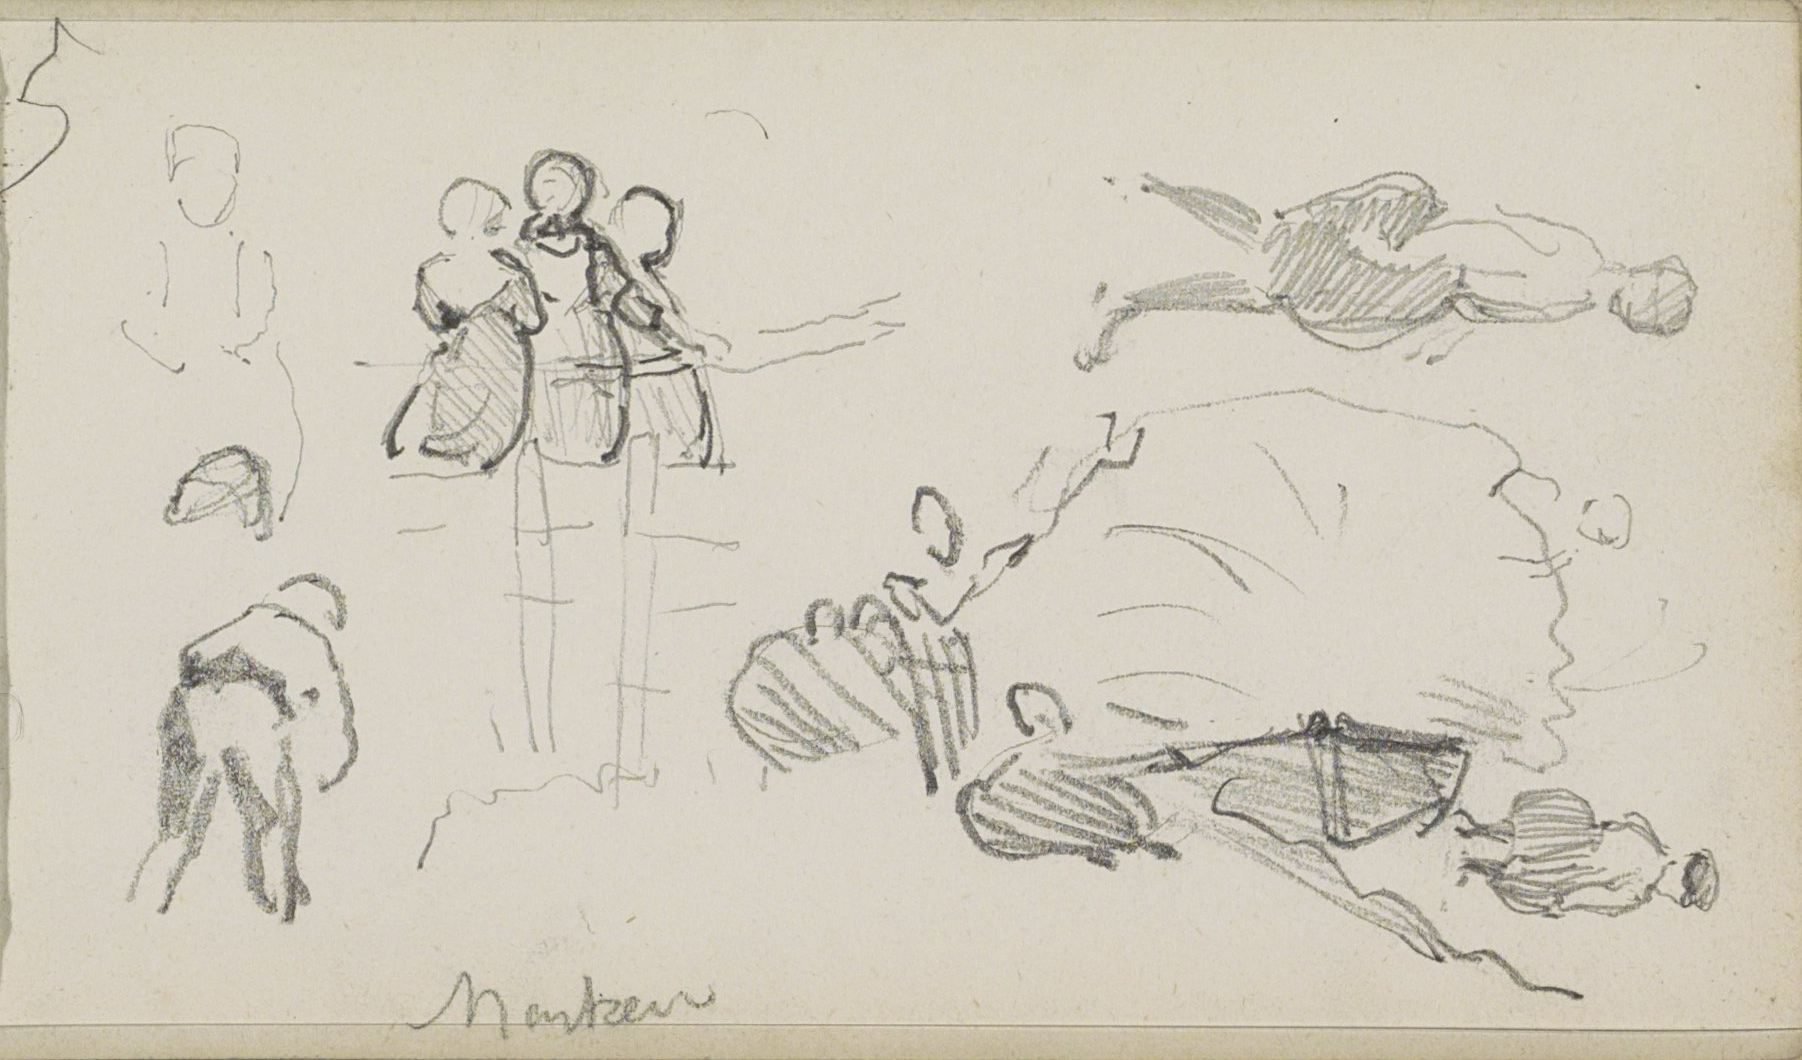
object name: sketchbook leaf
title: Inwoners van Marken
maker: george clausen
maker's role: draughtsman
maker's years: 1852-1912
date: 1875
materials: paper, pencil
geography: marken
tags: standing figure, sitting figure, folk costume, regional costume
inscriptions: annotation: ‘Marken’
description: De figuren, waaronder meisjes en mannen, dragen traditioneel Marker klederdracht en zijn in verschillende houdingen te zien. Blad 6 recto uit een schetsboek met 46 bladen.